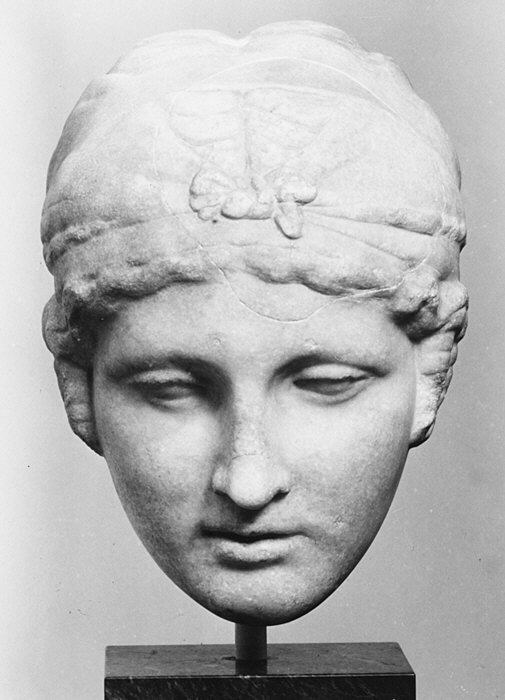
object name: head of a woman wearing sphendone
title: Statue portrait of Sappho?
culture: roman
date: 31-330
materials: marble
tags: heads,portraits